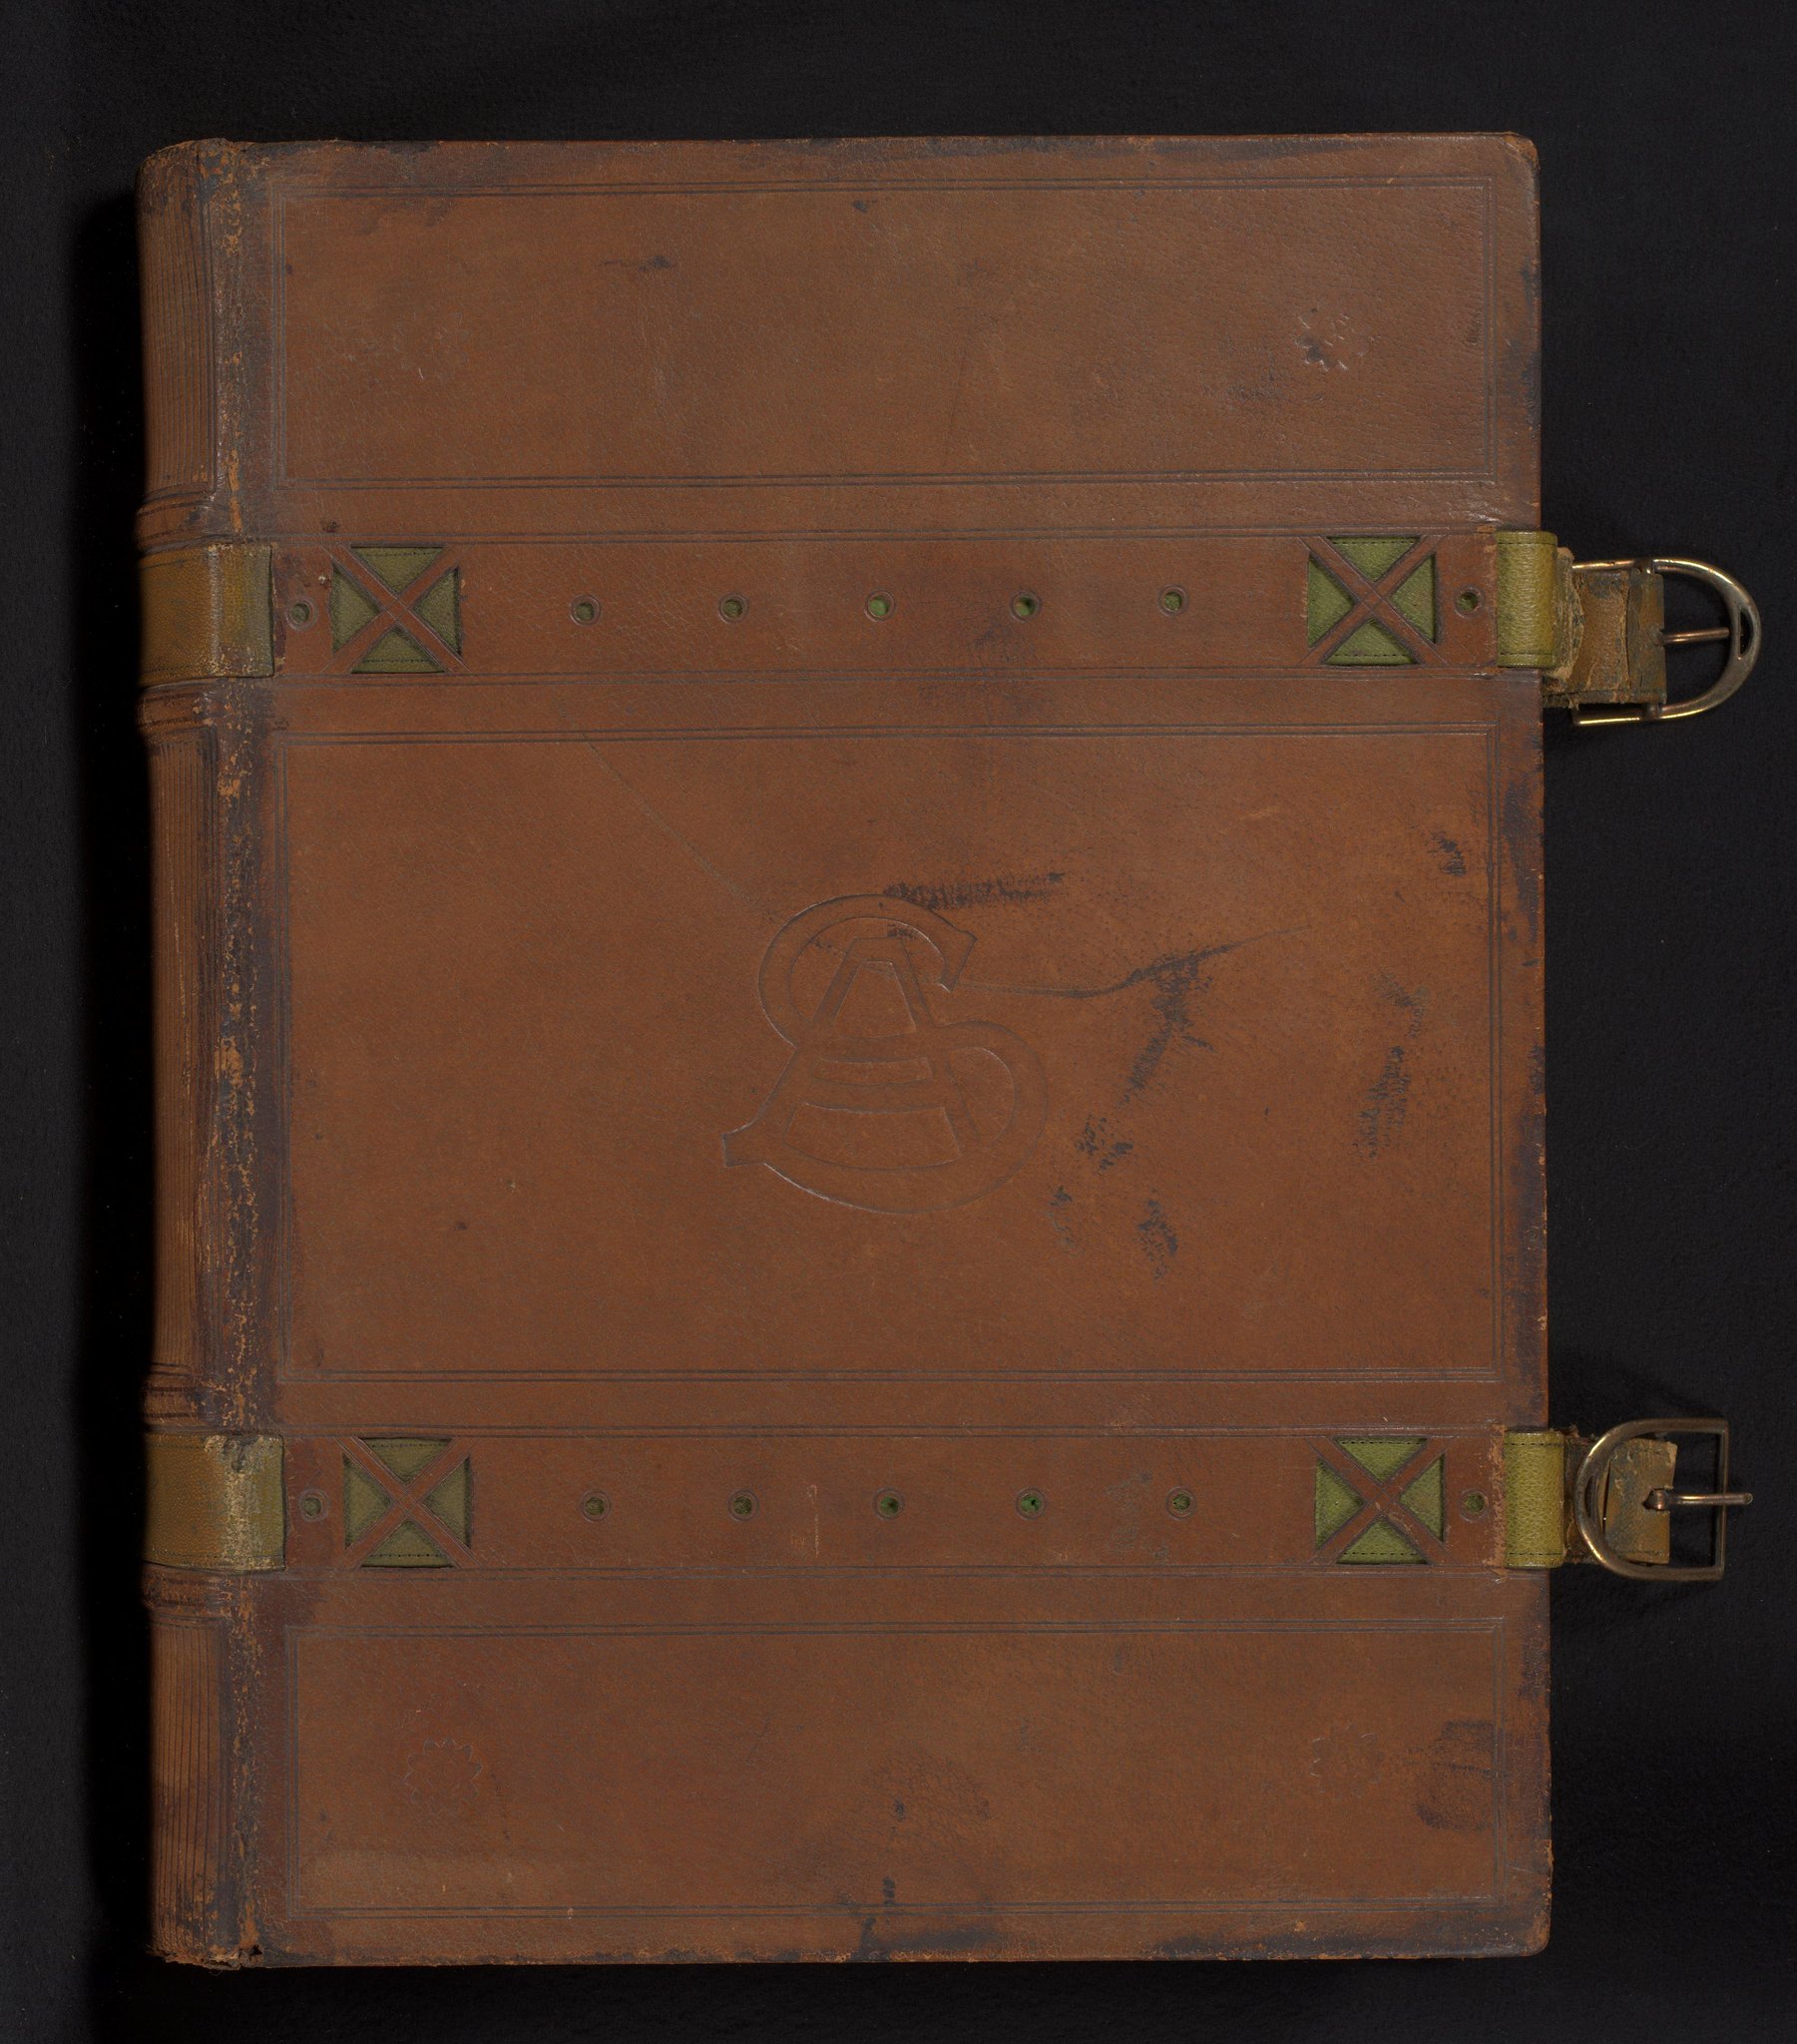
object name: slip in album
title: Familiealbum van de familie Schröder met 112 foto's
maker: Anonymous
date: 1860-1900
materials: cardboard, leather, paper, photographic support, textile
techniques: albumen print, gelatin silver print, platinum process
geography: amsterdam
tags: historical persons - bb - woman, child, historical persons, family, relationship, descent, infant, baby ~ the ages of man, netherlands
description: Fotoalbum met 36 pagina's met in totaal 112 foto's. Iedere pagina bevat met groene lijnen omkaderde passe-partouts om cartes-de-visites, kabinetfoto's en enkele andere formaten foto's in te steken. Niet alle passe-partouts zijn gevuld. Het album bevat 67 cartes-de-visite, 37 kabinetfoto's en 8 foto's van overige formaten. Afgebeeld zijn 107 portretten van mannen, vrouwen en kinderen, vermoedelijk uit de familie Schröder, en 5 foto's van honden. Van slechts één geportretteerde is de naam bekend: Joan Herman Anne Kruimel. De foto's zijn gemaakt door verschillende fotografen, waaronder 23 foto's door Wegner & Mottu, 19 foto's door Koene & Büttinghausen en 8 foto's door Woodbury & Page. Van 29 foto's is de vervaardiger anoniem.